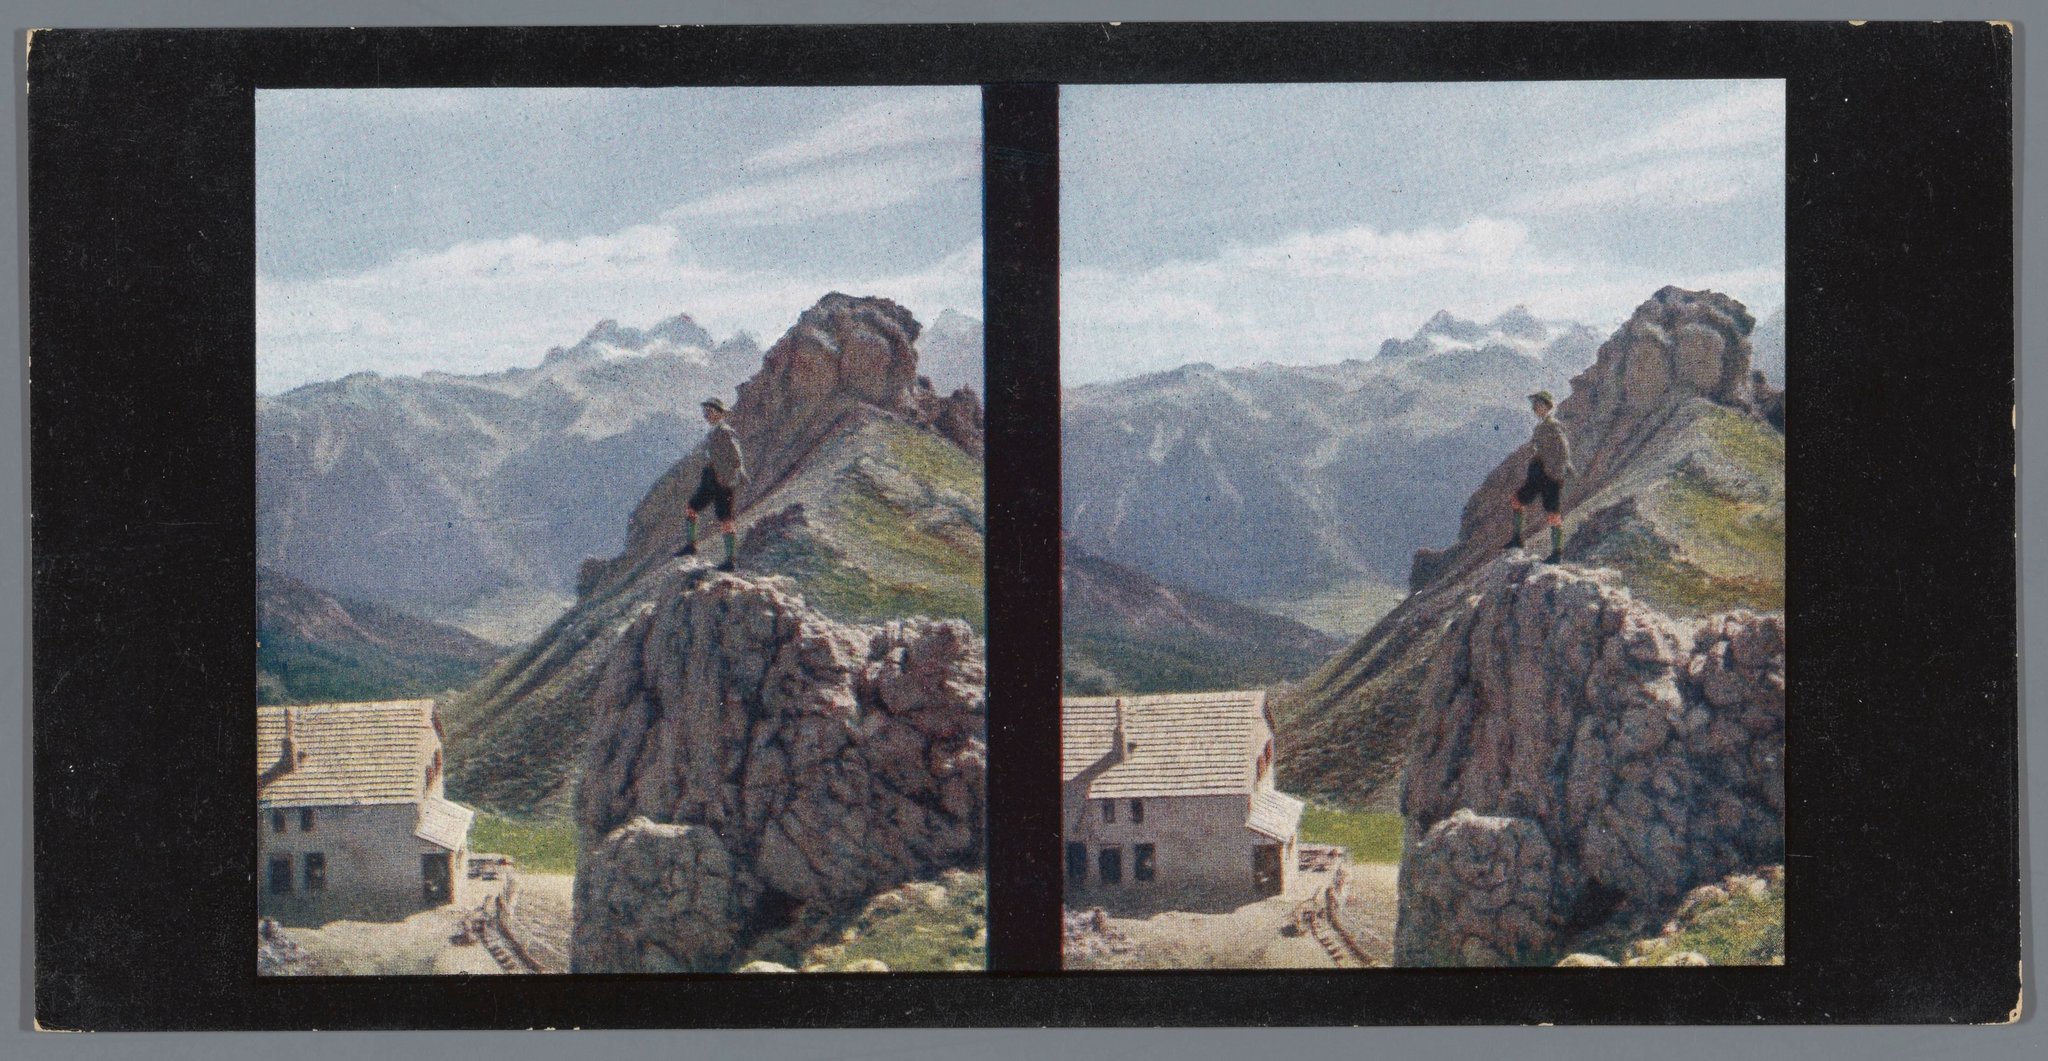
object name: stereograph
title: Ostertaghütte.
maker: hans hildenbrand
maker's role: fotograaf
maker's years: 1870-1957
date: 1902-1908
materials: cardboard, ink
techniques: color autotype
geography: dolomites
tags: hut, cabin, lodge, mountains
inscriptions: inscription: ‘,,Chromoplast''-Bild.’, inscription: ‘Beste Wirkung bei Betrachtung durch das ,, Isostereo''.’, number: ‘Nr. 26.’, inscription: ‘Warenzeichen 142 123.’, inscription: ‘D. R. G. M. Nr. 437 756.’